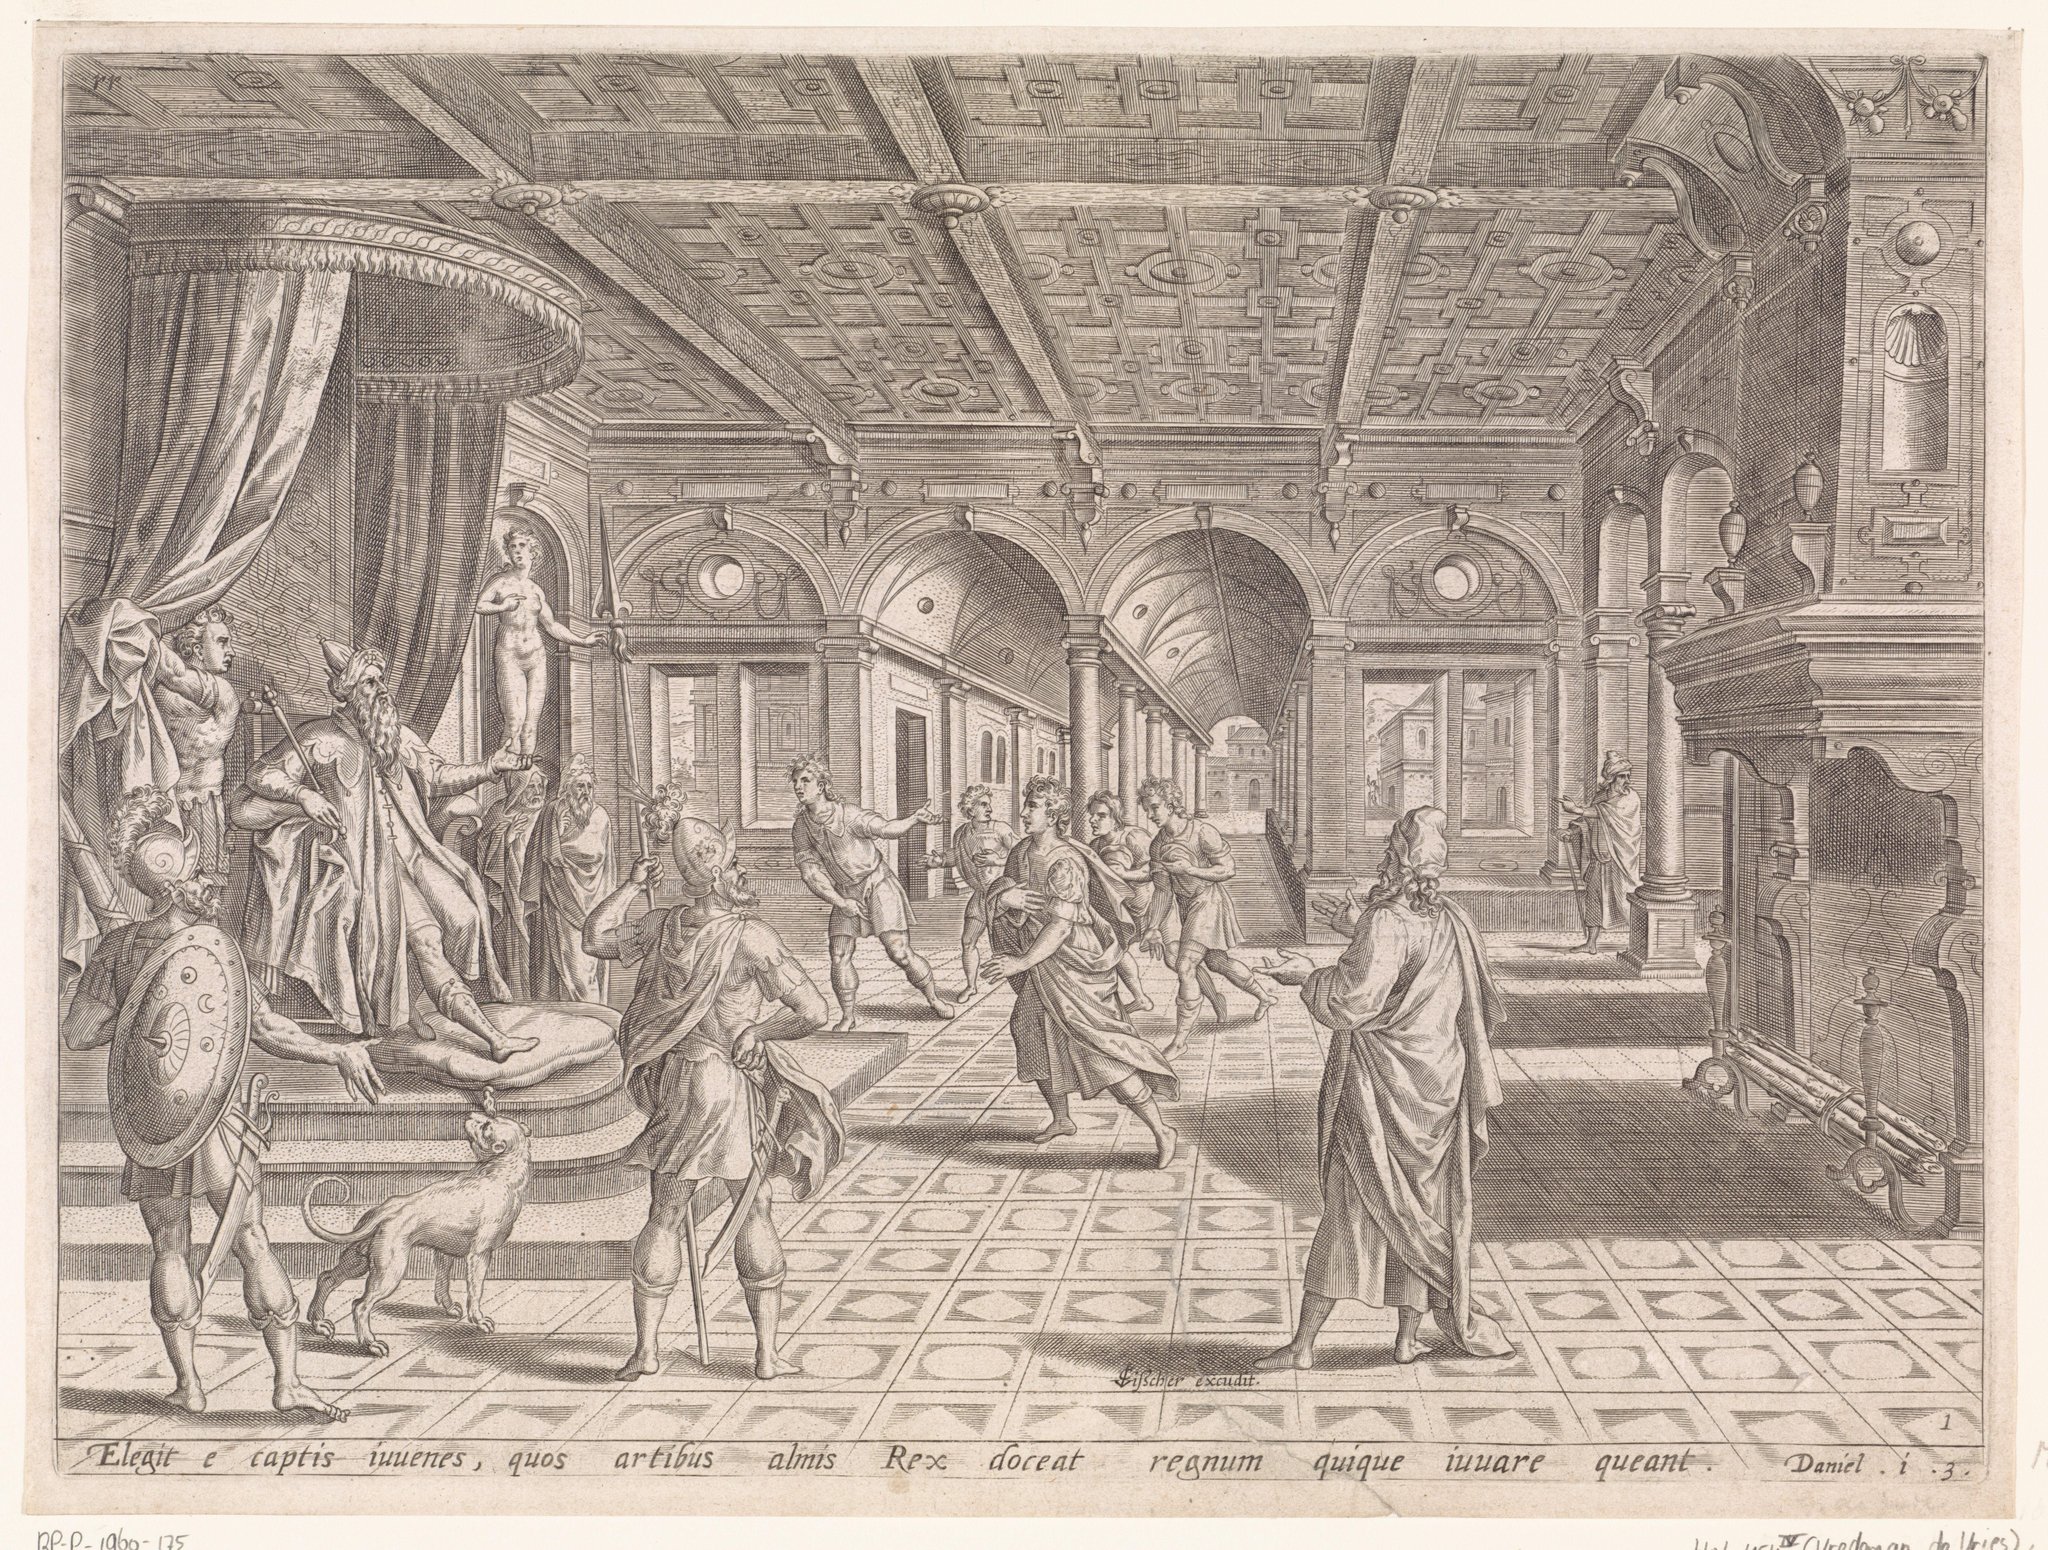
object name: print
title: Geschiedenis van Daniël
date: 1579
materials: paper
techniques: etching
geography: amsterdam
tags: israelites (usually four) are brought before the prince of eunuchs because king nebuchadnezzar wants to have them educated in the palace (daniel 1)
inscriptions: collector's mark: Lugt 2228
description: Daniël en drie andere jonge Israëlieten worden aan koning Nebukadnessar gepresenteerd. De koning, links op de troon, geeft de opdracht hen te onderrichten, zodat ze geschikt worden om in dienst van de koning te treden. Onder de voorstelling een verwijzing in het Latijn naar de Bijbeltekst in Dan. 1:3.